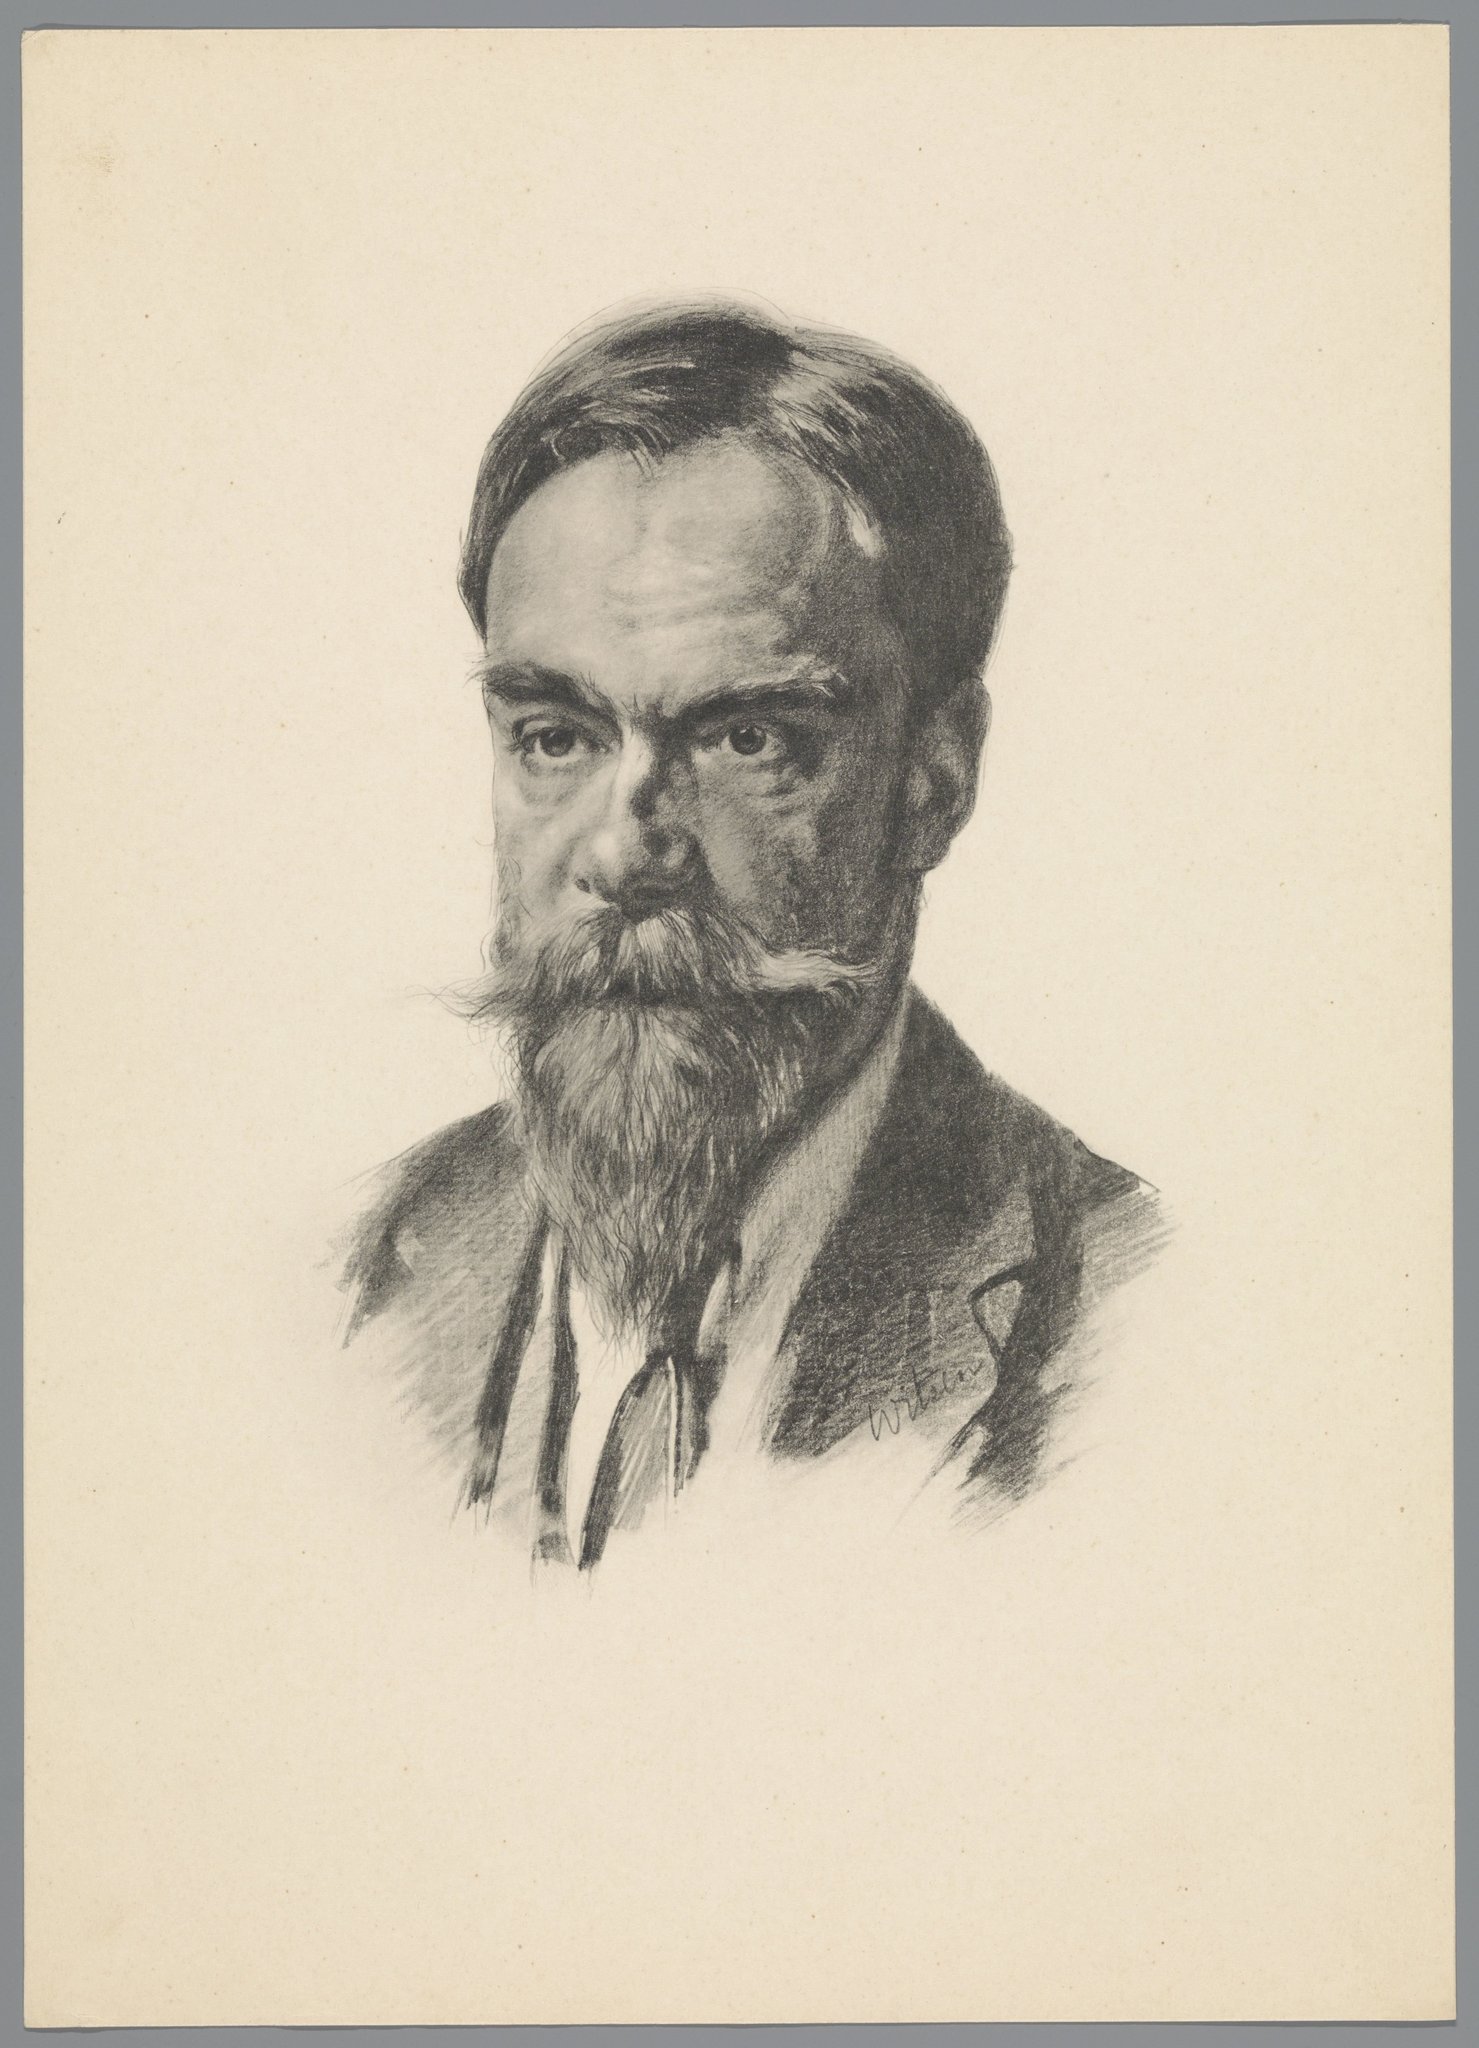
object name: print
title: Reproductie naar krijttekening met portret van Frans Coenen Jr.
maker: Anonymous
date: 1860-1915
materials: paper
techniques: photograph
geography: netherlands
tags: frans coenen (1866-1936)